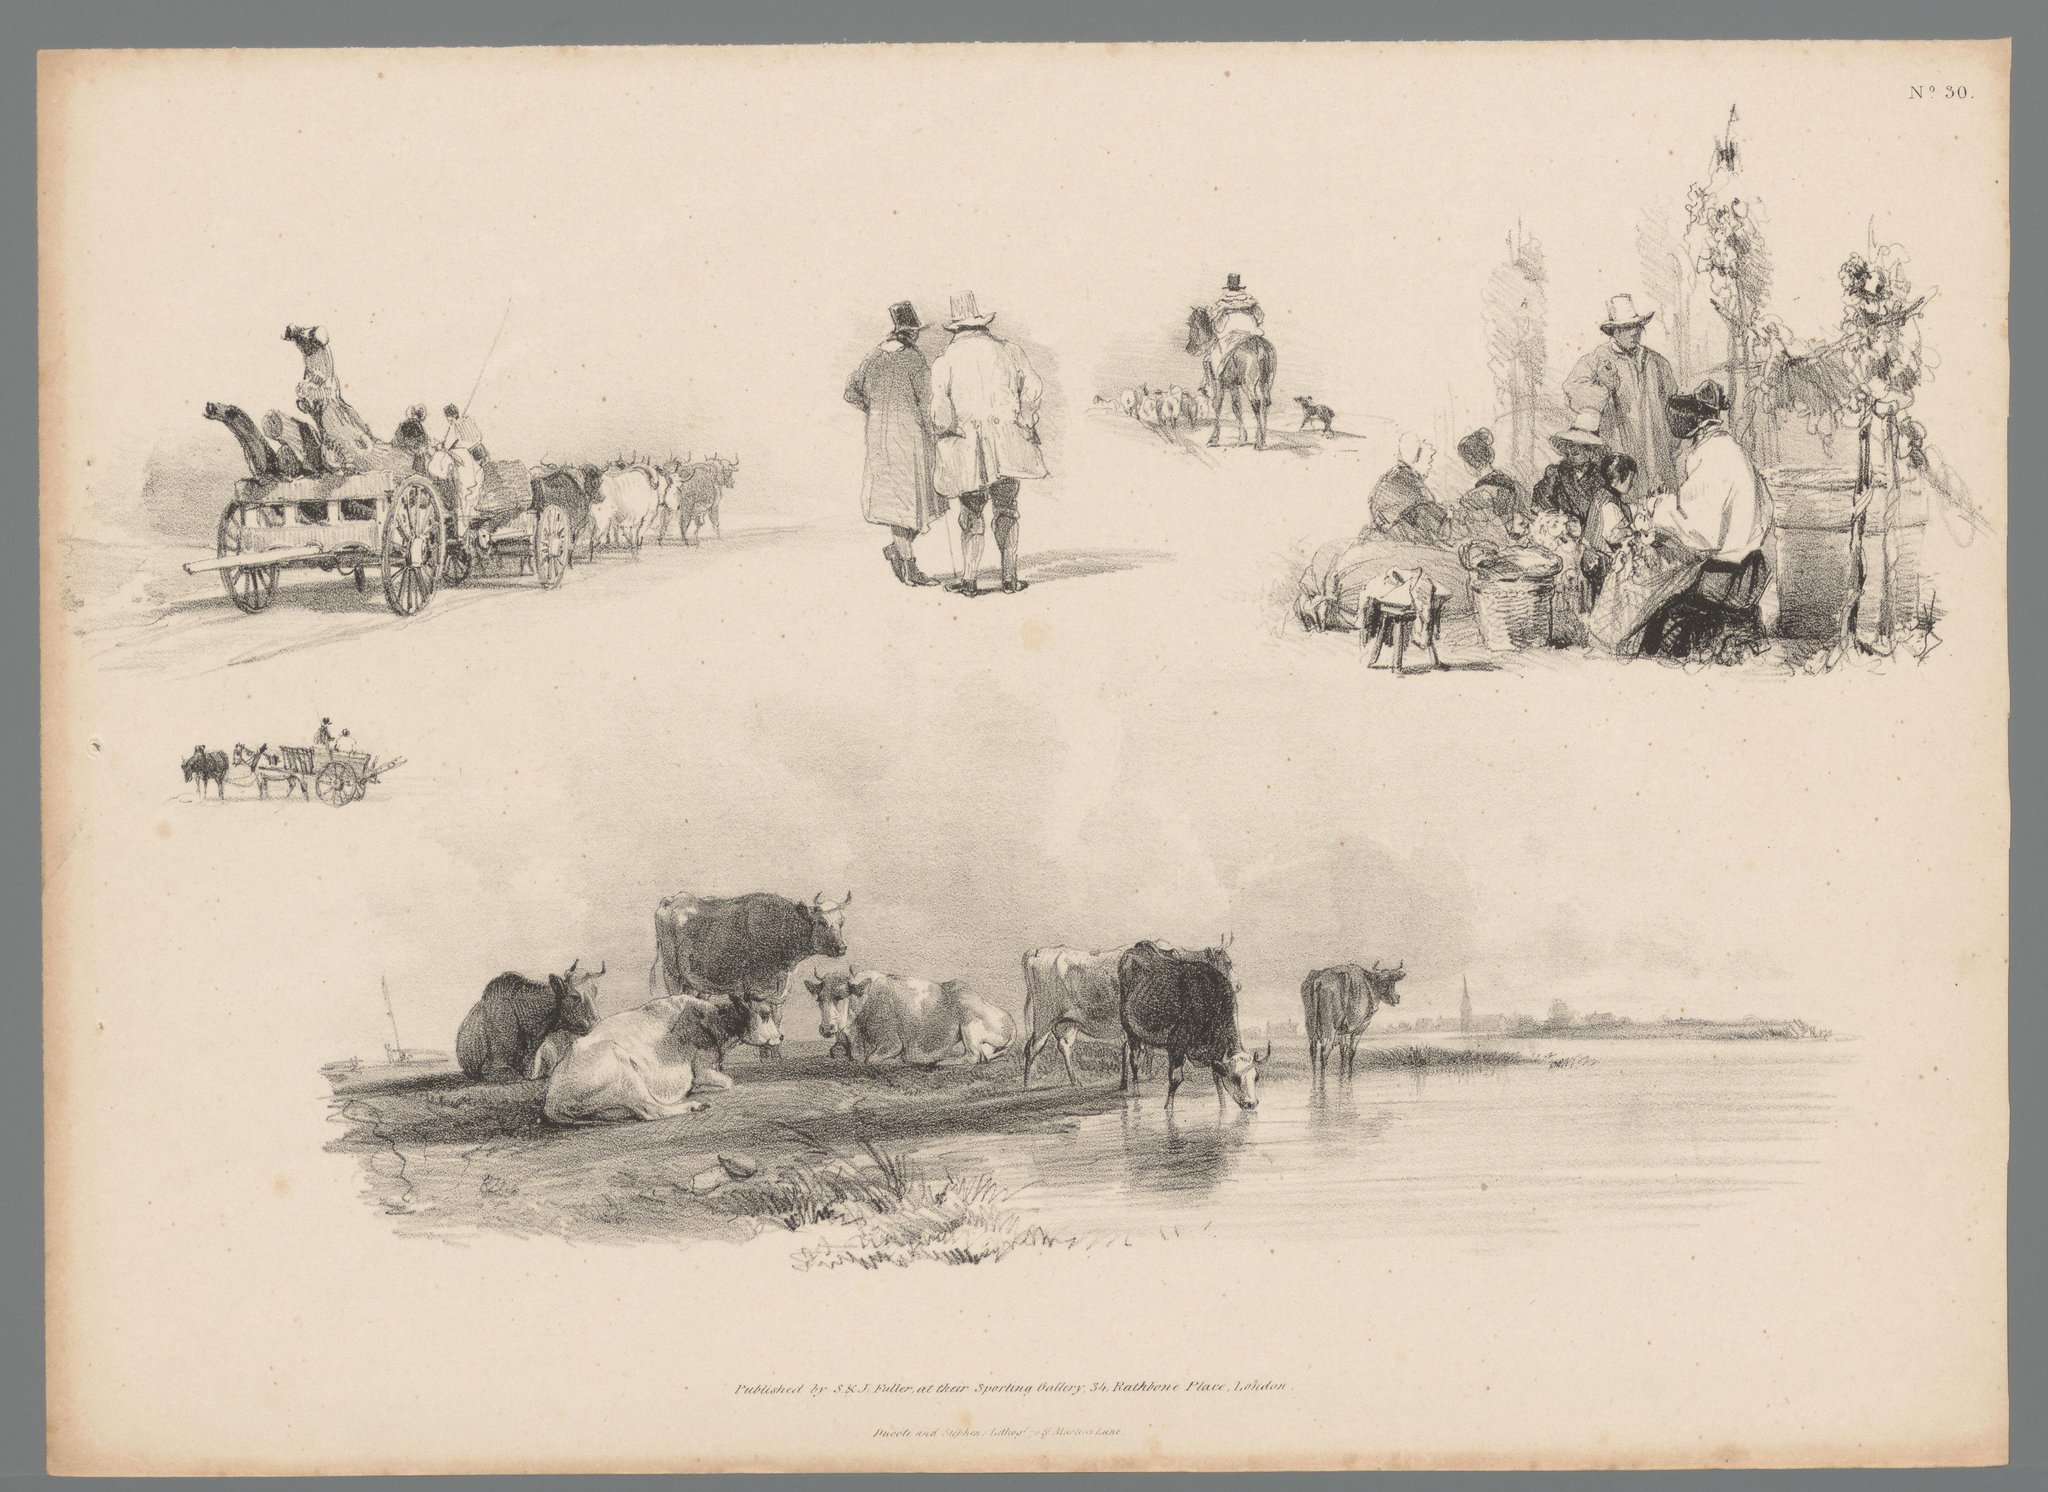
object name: print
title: Voorstellingen van vee door Thomas Sidney Cooper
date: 1837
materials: paper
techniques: lithograph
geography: london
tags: cattle, four-wheeled, animal-drawn vehicle, e.g.: cab, carriage, coach, landscapes (+ landscape with figures, staffage)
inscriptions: collector's mark: Lugt 2228